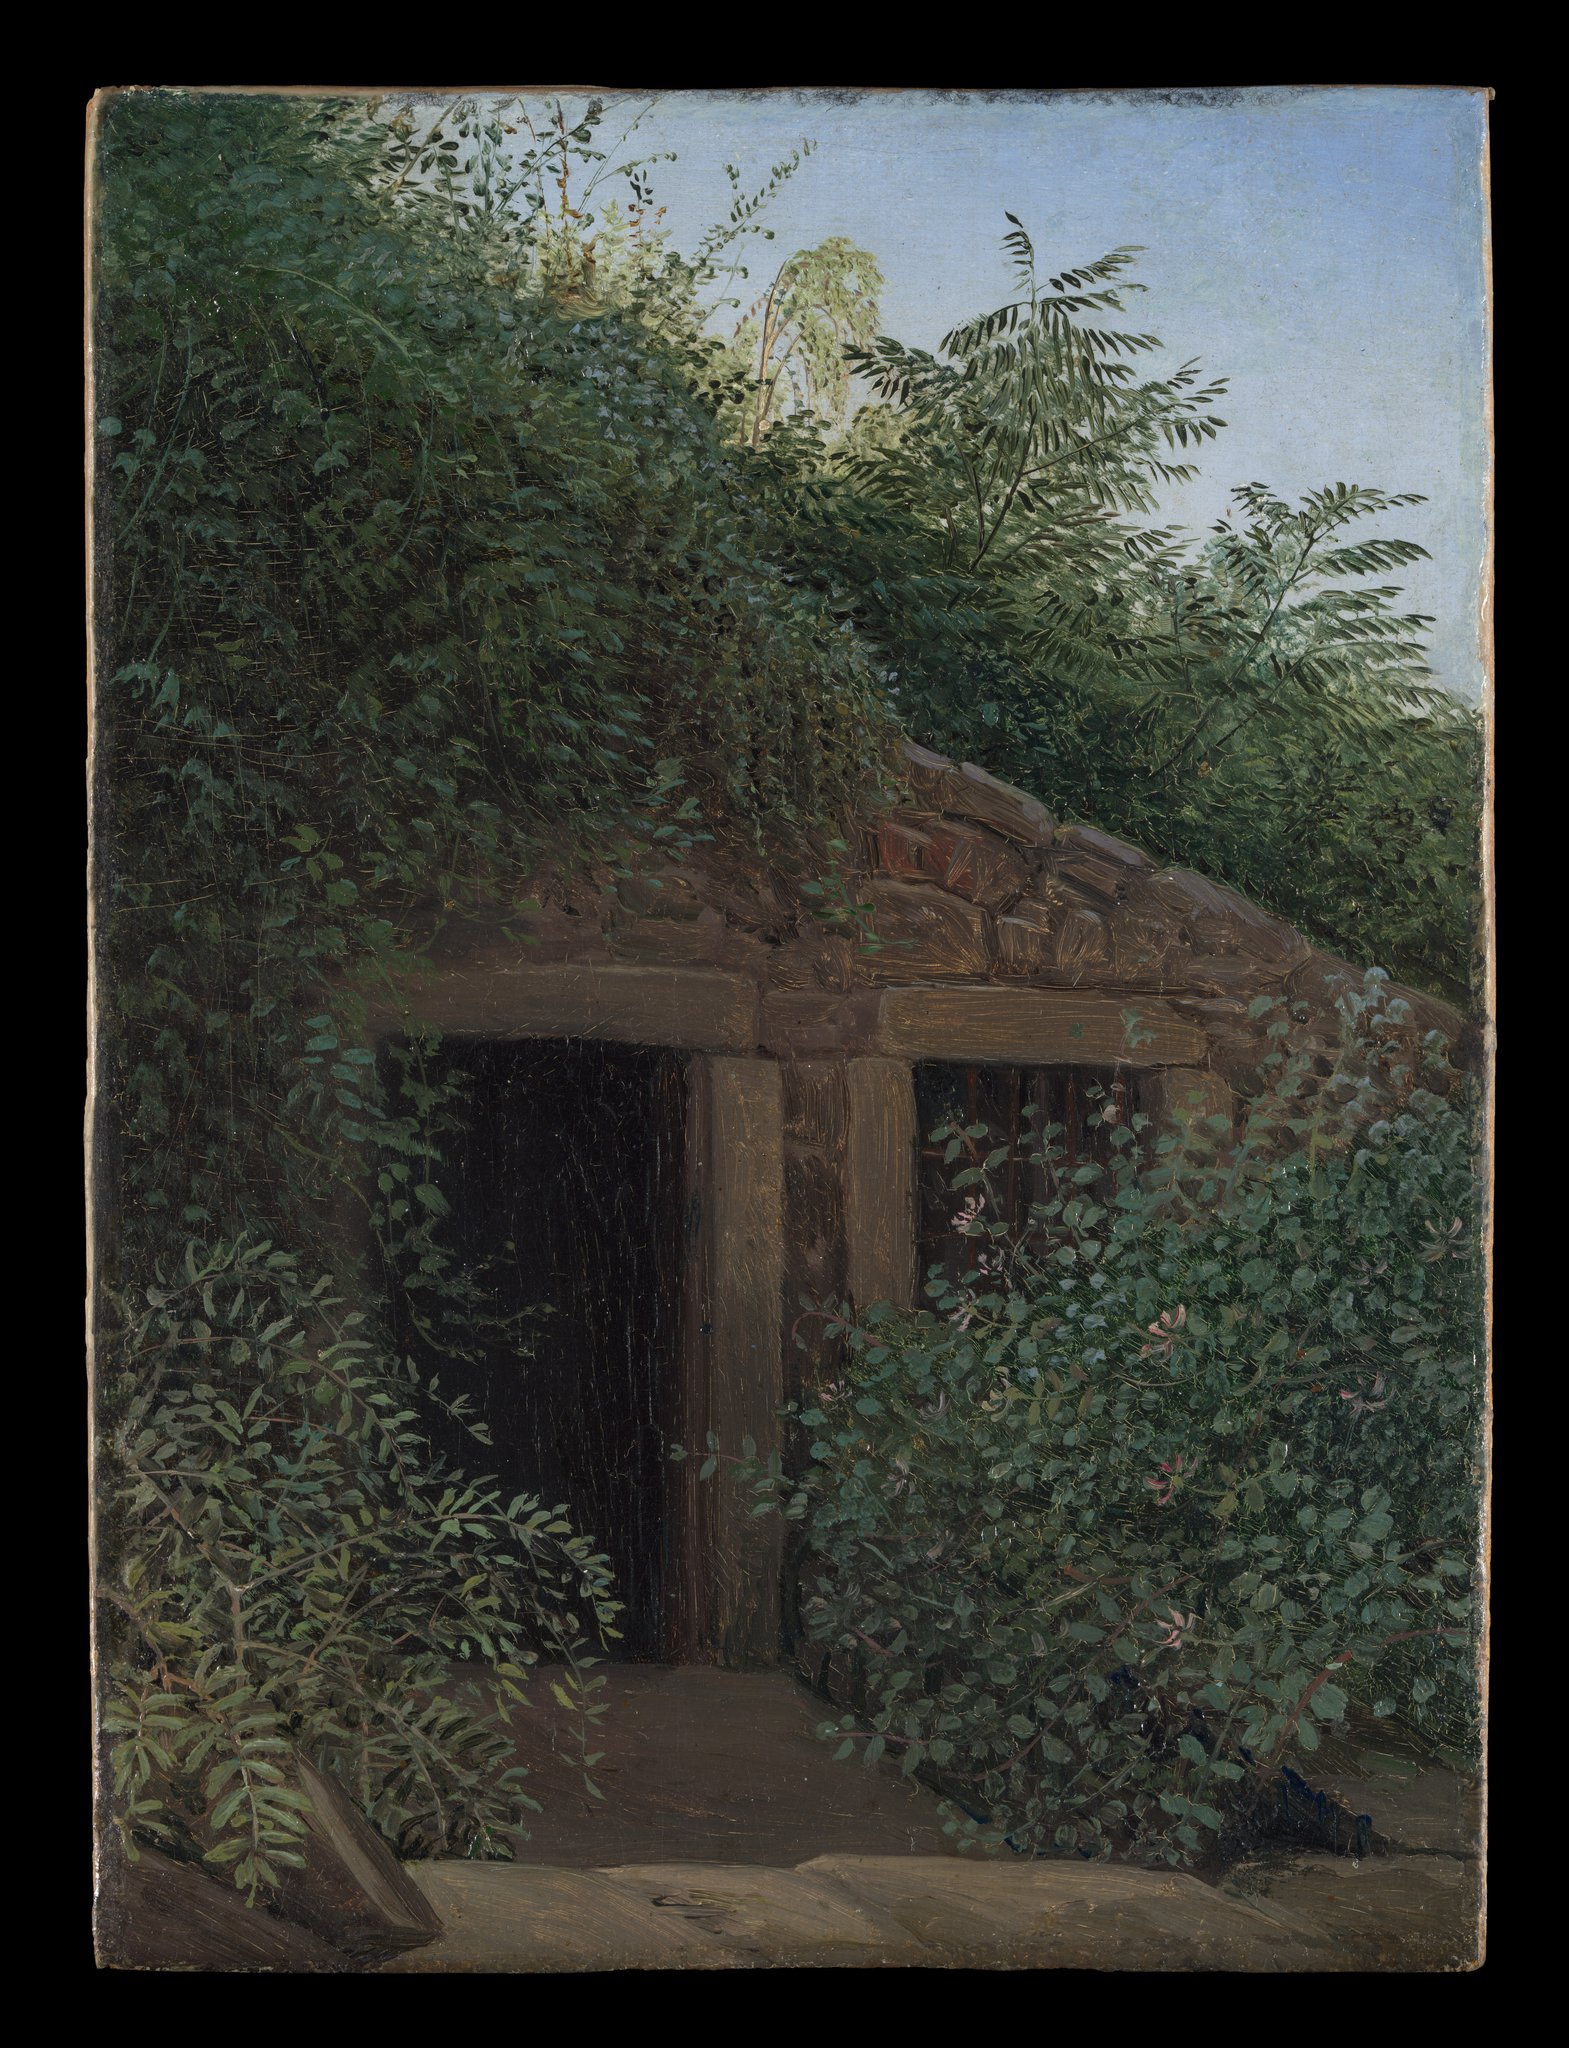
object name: painting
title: An Overgrown Mineshaft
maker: carl gustav carus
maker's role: artist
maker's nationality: german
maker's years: 1789-1869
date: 1824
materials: cardboard, oil, paper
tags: doorways